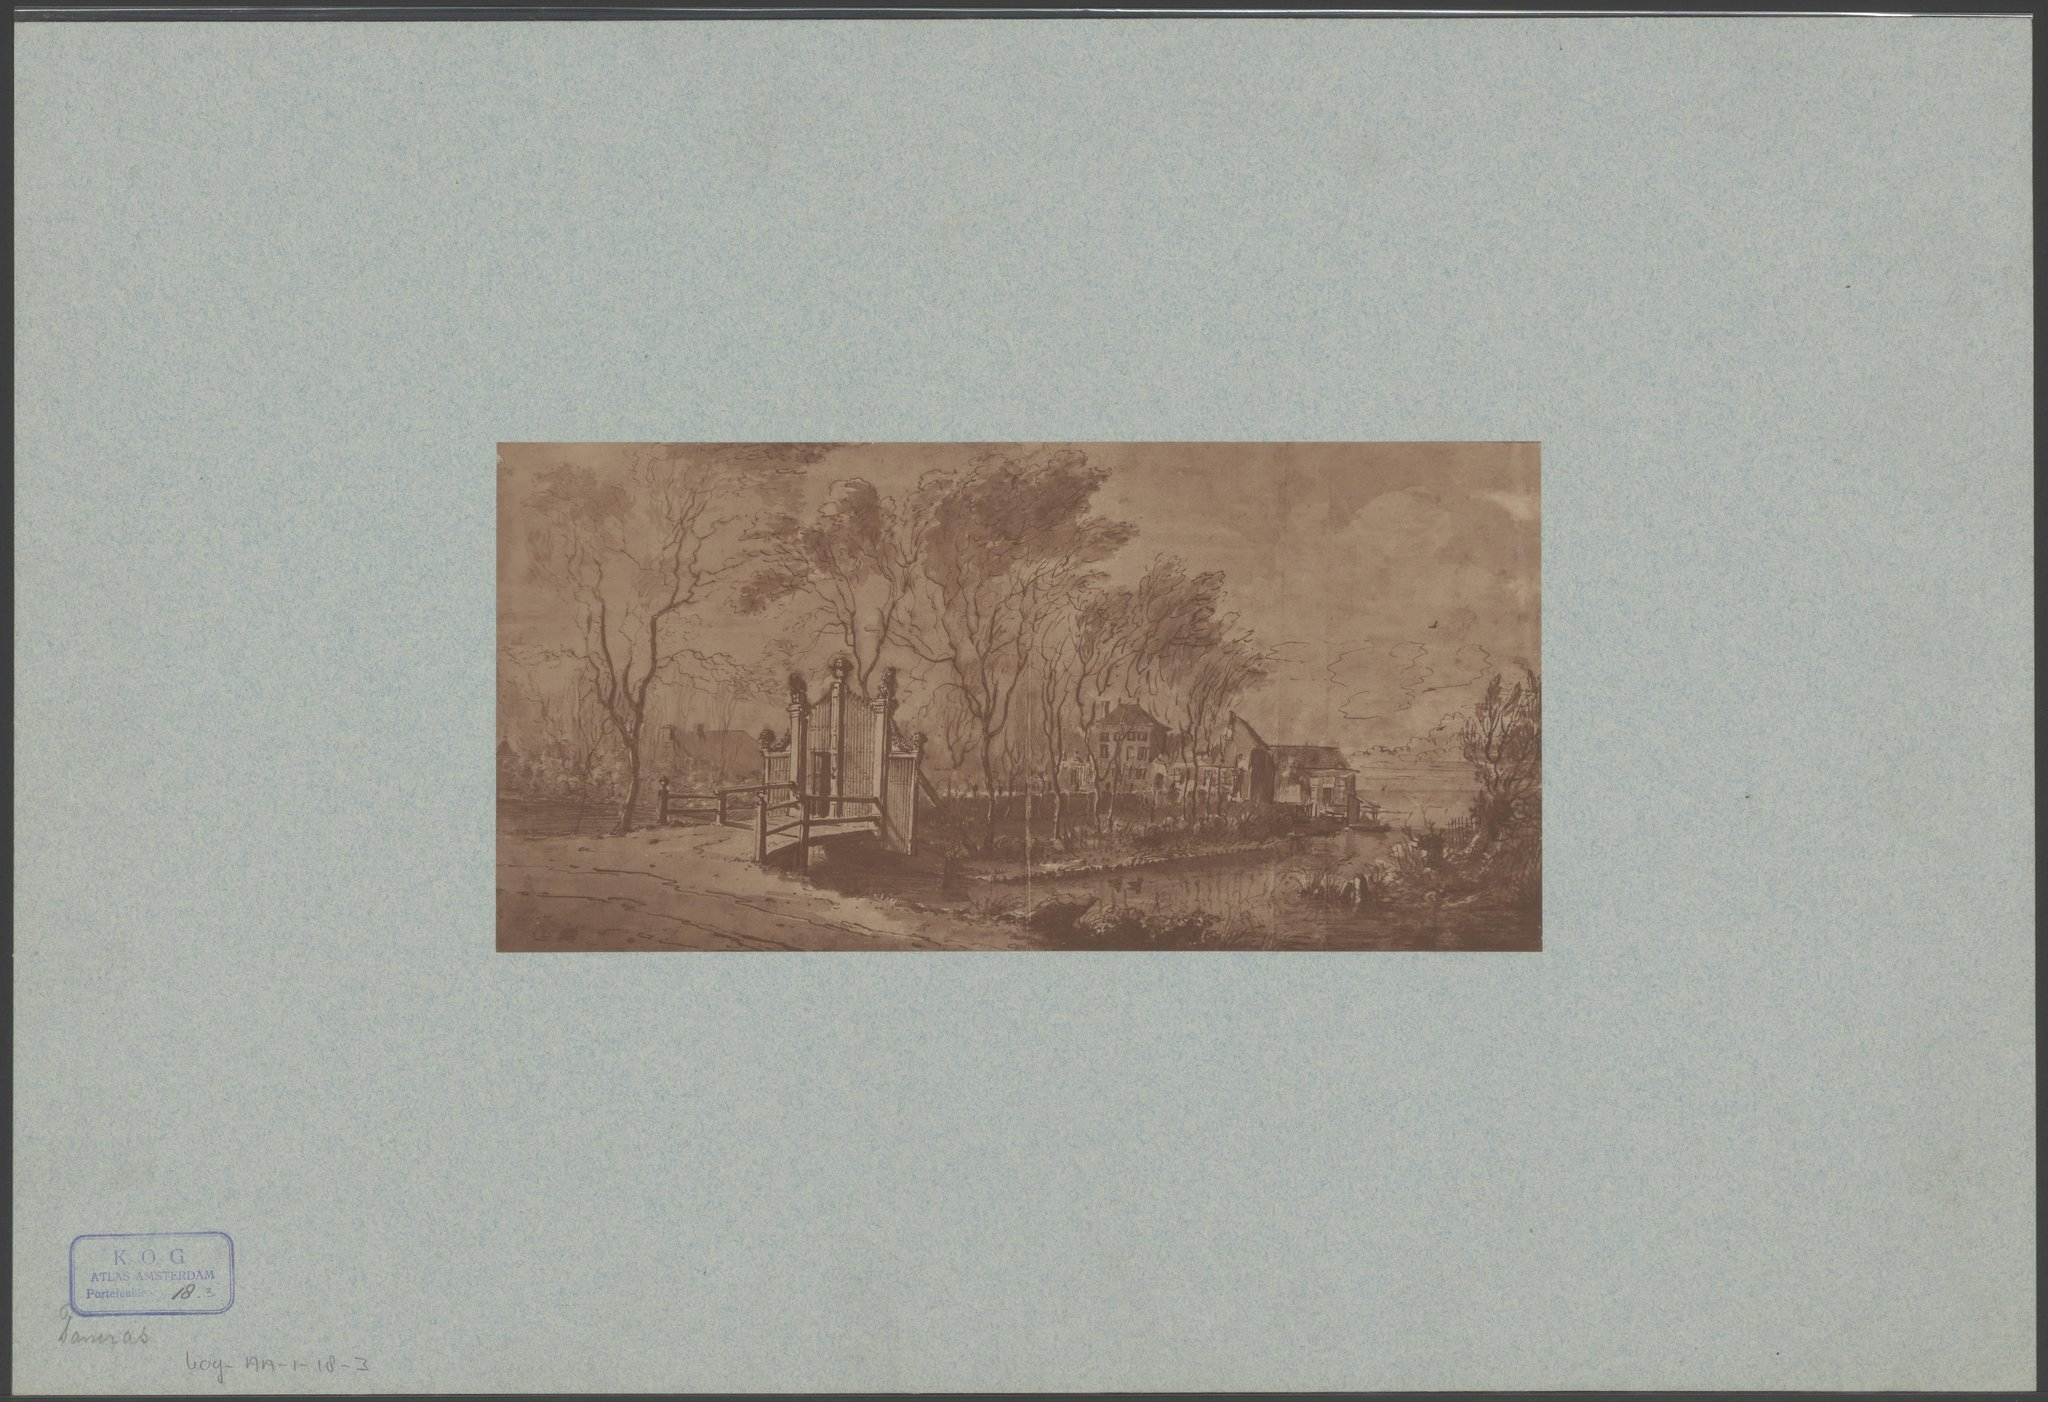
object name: photograph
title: Gezicht op de buitenplaats van Gerbrand Pancras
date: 1890-1940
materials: paper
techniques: carbon print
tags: gerbrand pancras (burgemeester), gate, entrance, country-house, amsterdam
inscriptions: collector's mark: ‘18.3’ Lugt 1641b, inscription: ‘Deze tekening behoort (...) jufrouw / Blaeu getrouwd.’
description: Onderwerpsrubriek binnen de Atlas Amsterdam: Herinneringen aan regeringsleden en hunne huisgezinnen [voor 1800].